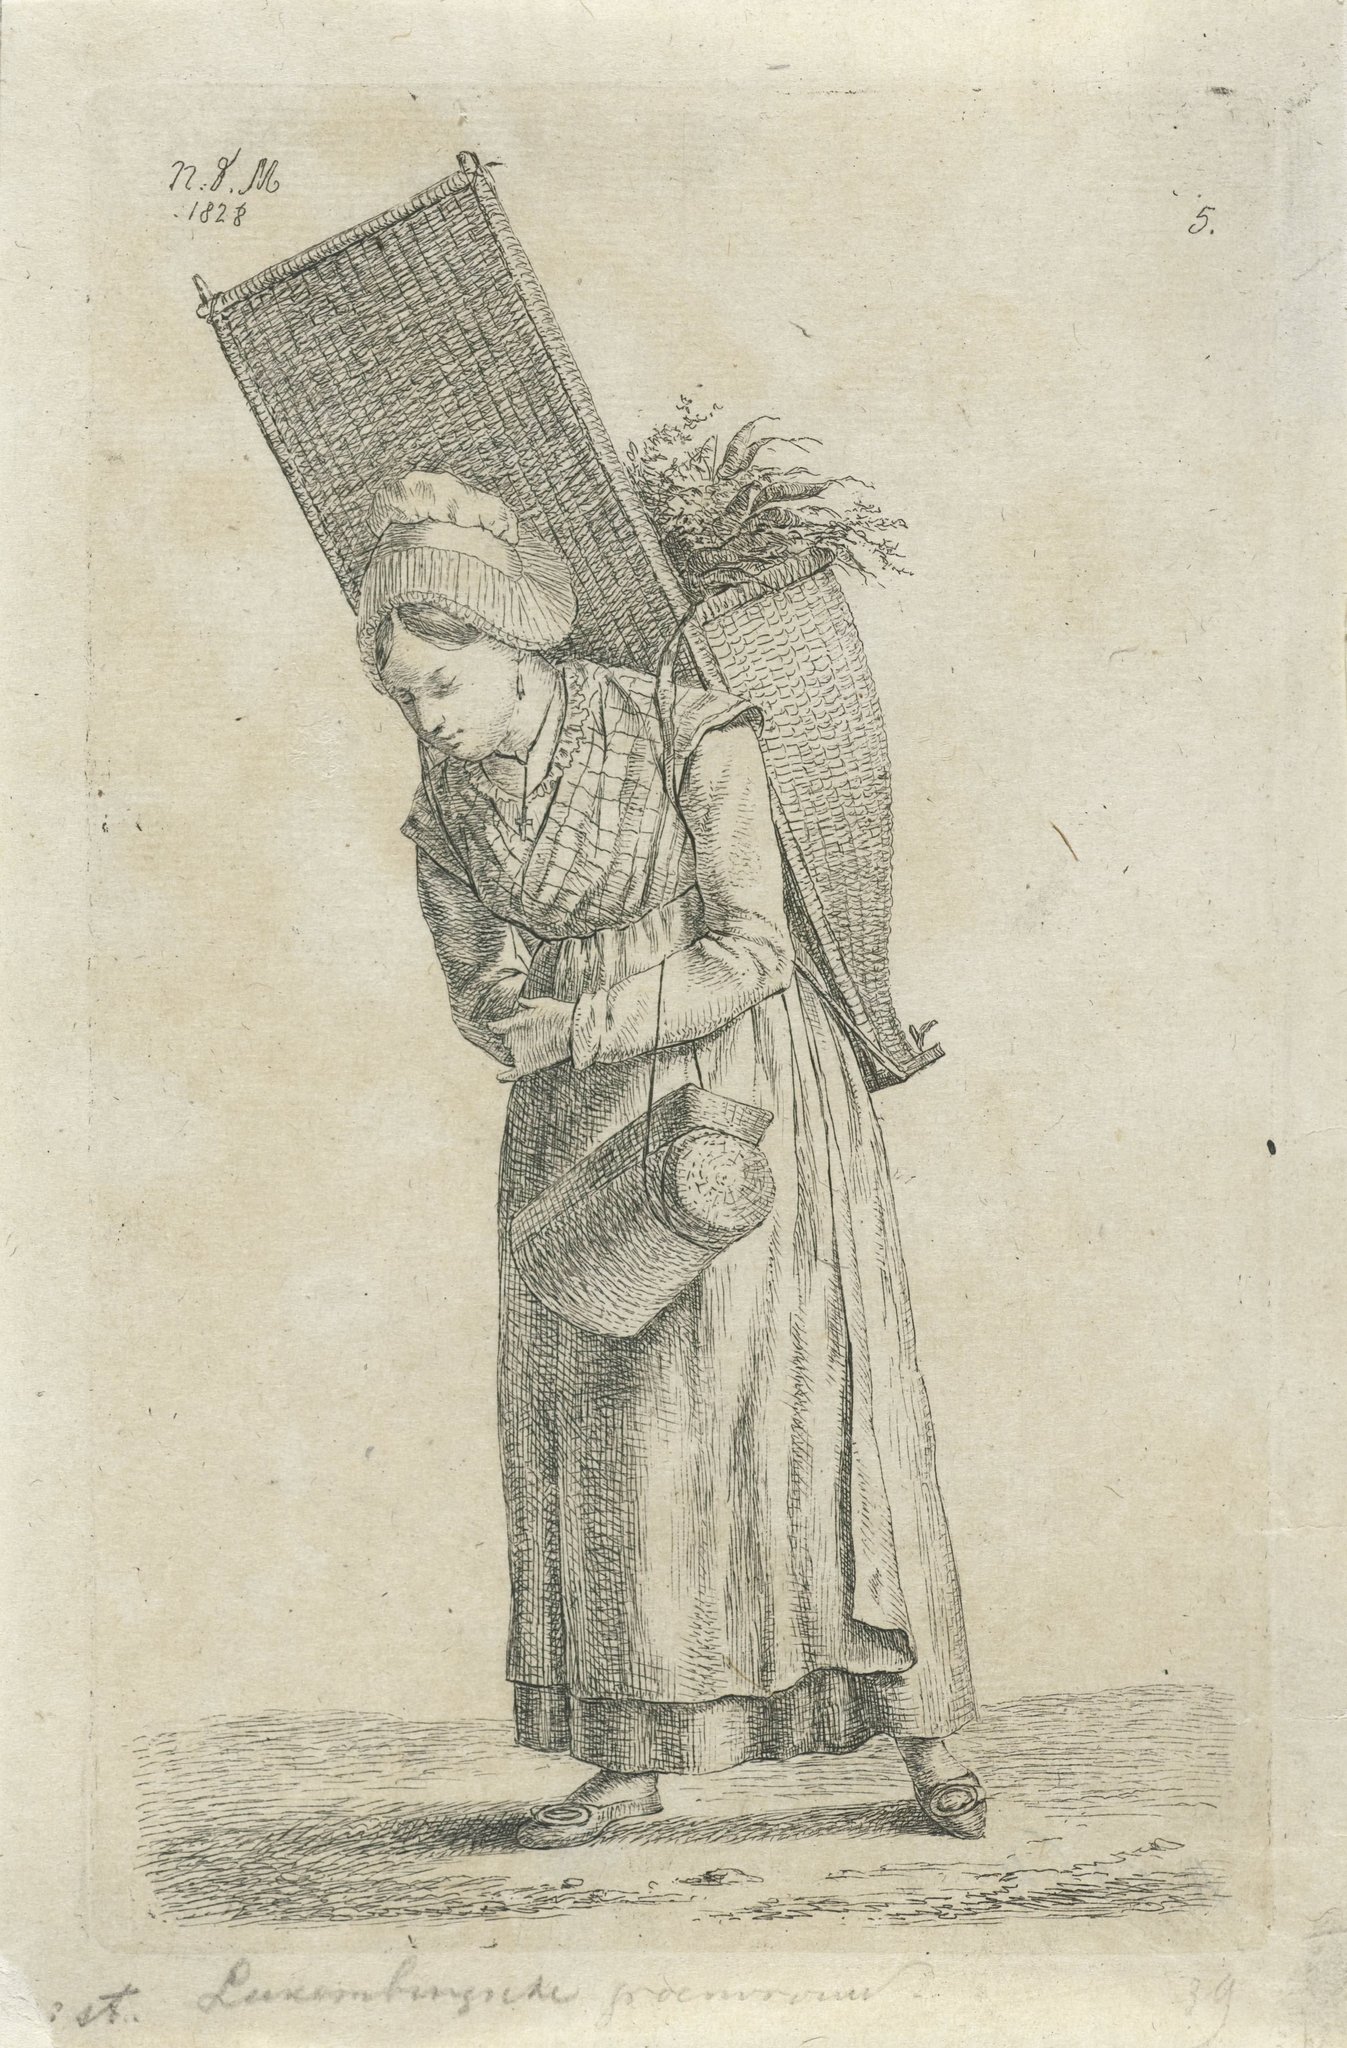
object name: print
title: Luxemburgsche groenvrouw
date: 1828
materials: paper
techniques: etching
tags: carrying something in basket, bag, rucksack, etc., container made of plant material other than wood: basket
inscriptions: collector's mark: Lugt 2227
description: Een vrouw uit Luxemburg met een mand op haar rug, waarin kruiden zitten. Aan haar arm nog een mand. Vijfde prent uit een serie van zes prenten met voorstellingen van verschillende boeren en boerinnen uit het Verenigd Koninkrijk der Nederlanden.